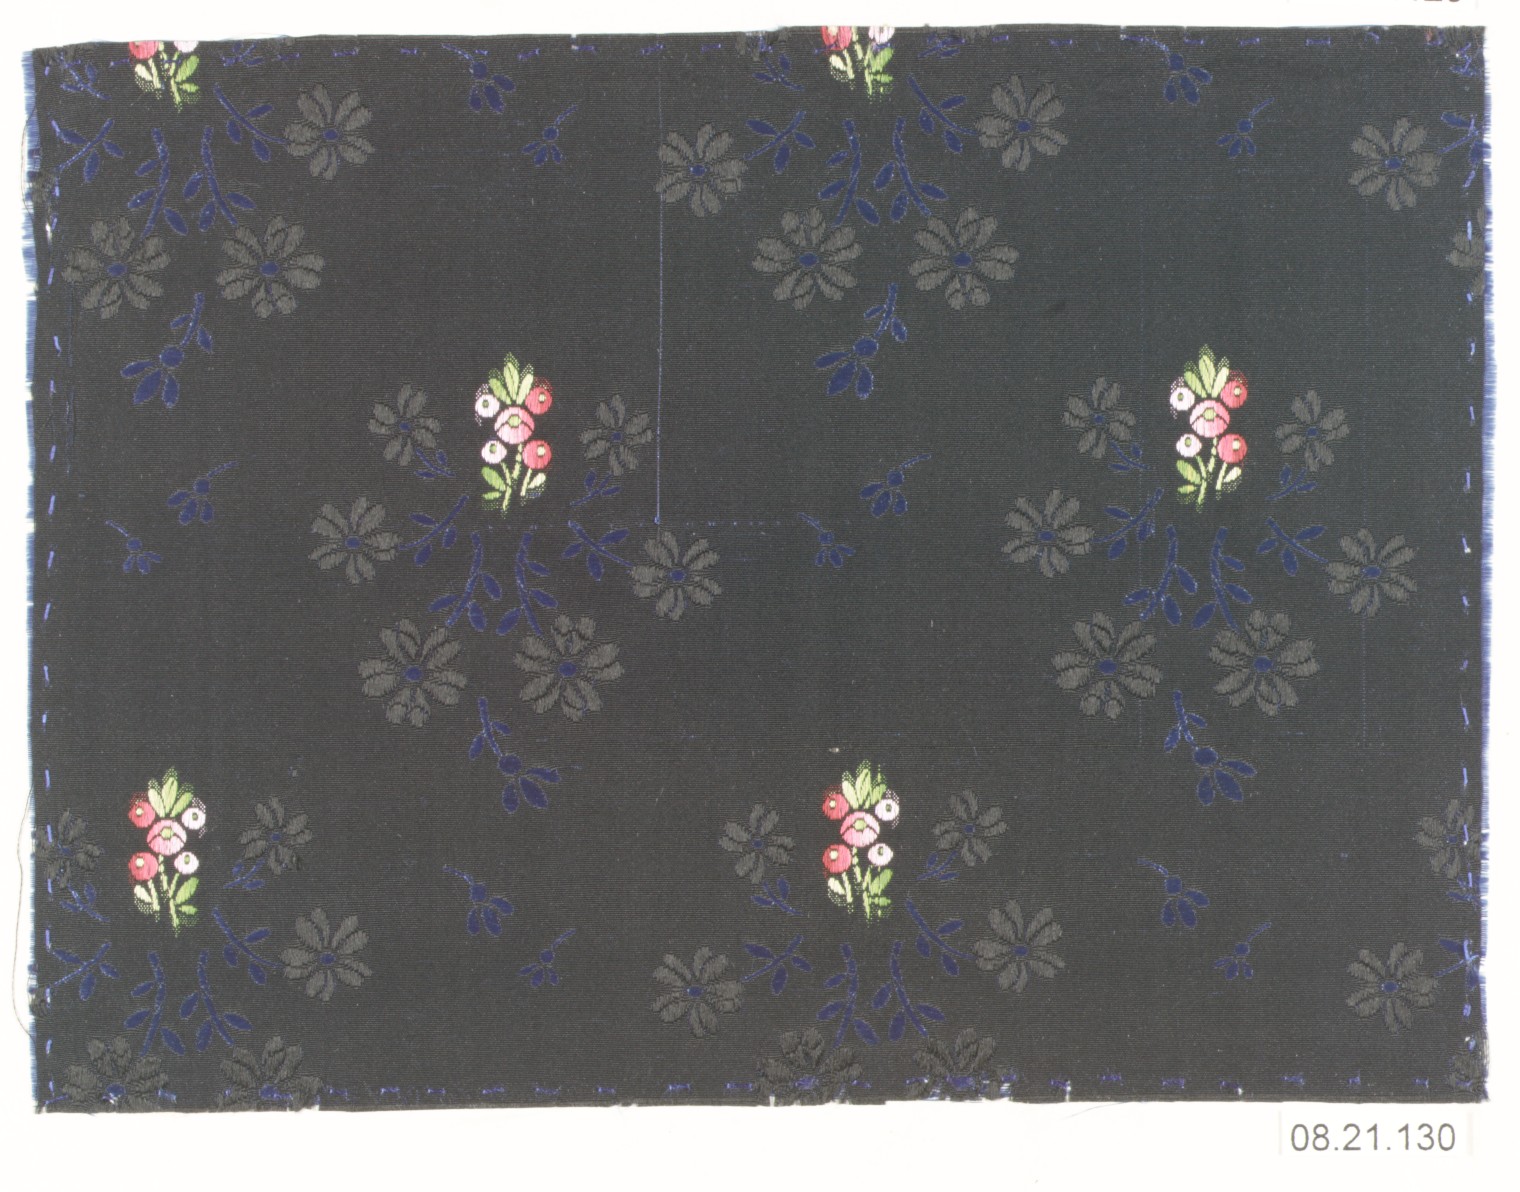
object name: textile sample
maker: Anonymous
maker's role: designer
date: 1900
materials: silk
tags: flowers